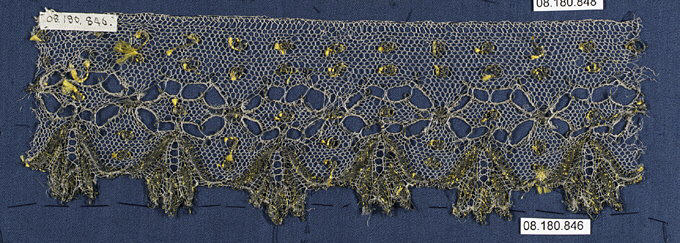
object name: piece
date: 1801-1900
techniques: lace